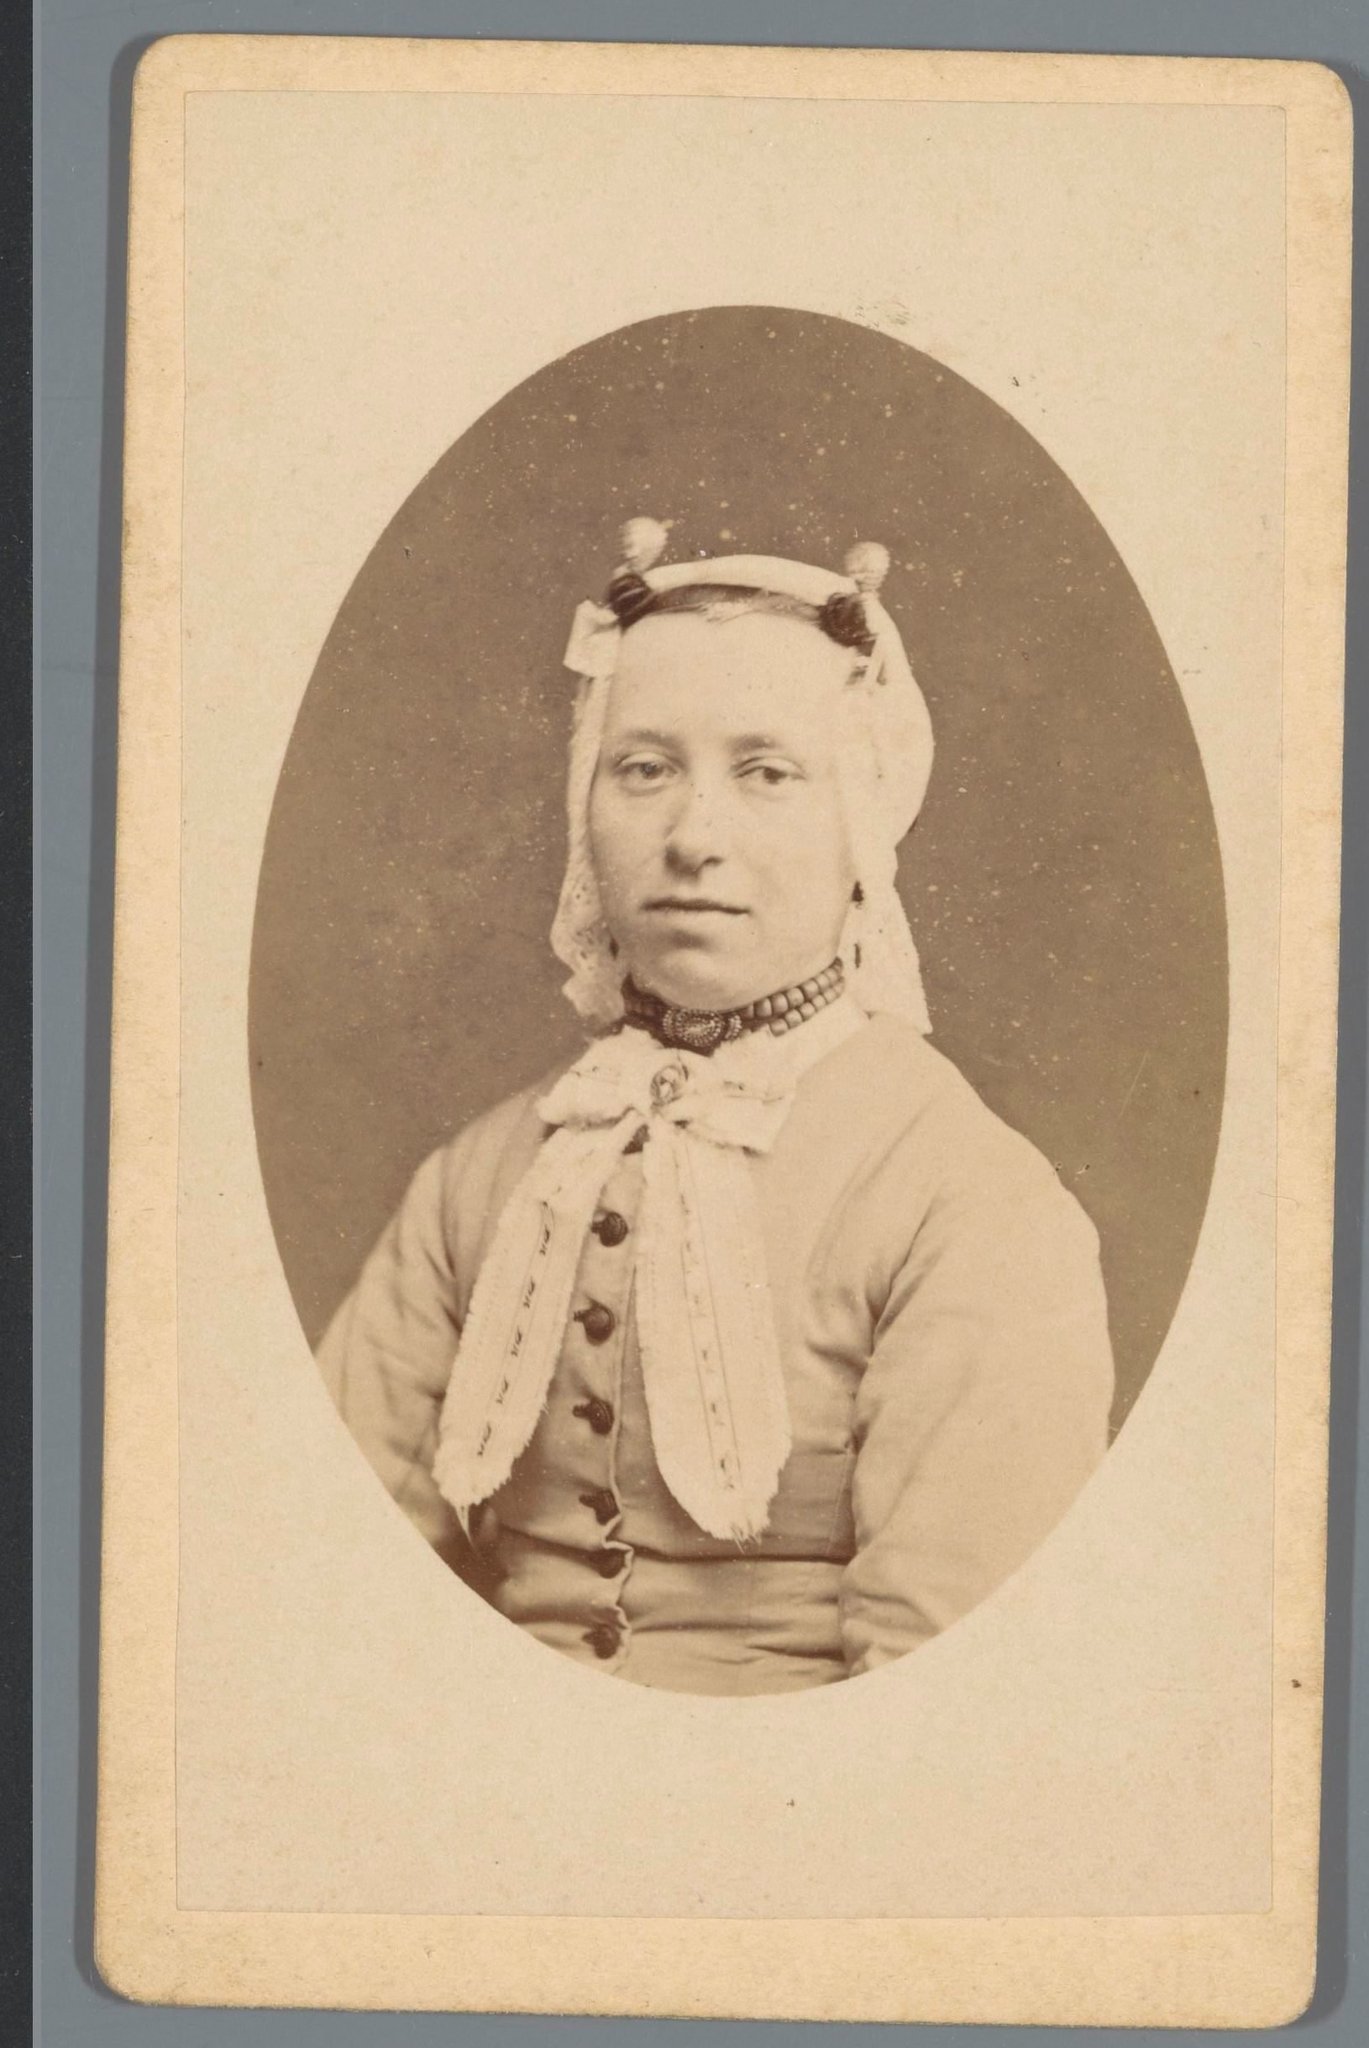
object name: carte de visite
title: Portret van een onbekende vrouw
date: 1873-1883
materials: cardboard, paper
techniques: albumen print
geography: hoorn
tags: adult woman, anonymous historical person portrayed, hoorn (north holland)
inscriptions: address: ‘op het plein a/h Groote Oost/ HOORN.’